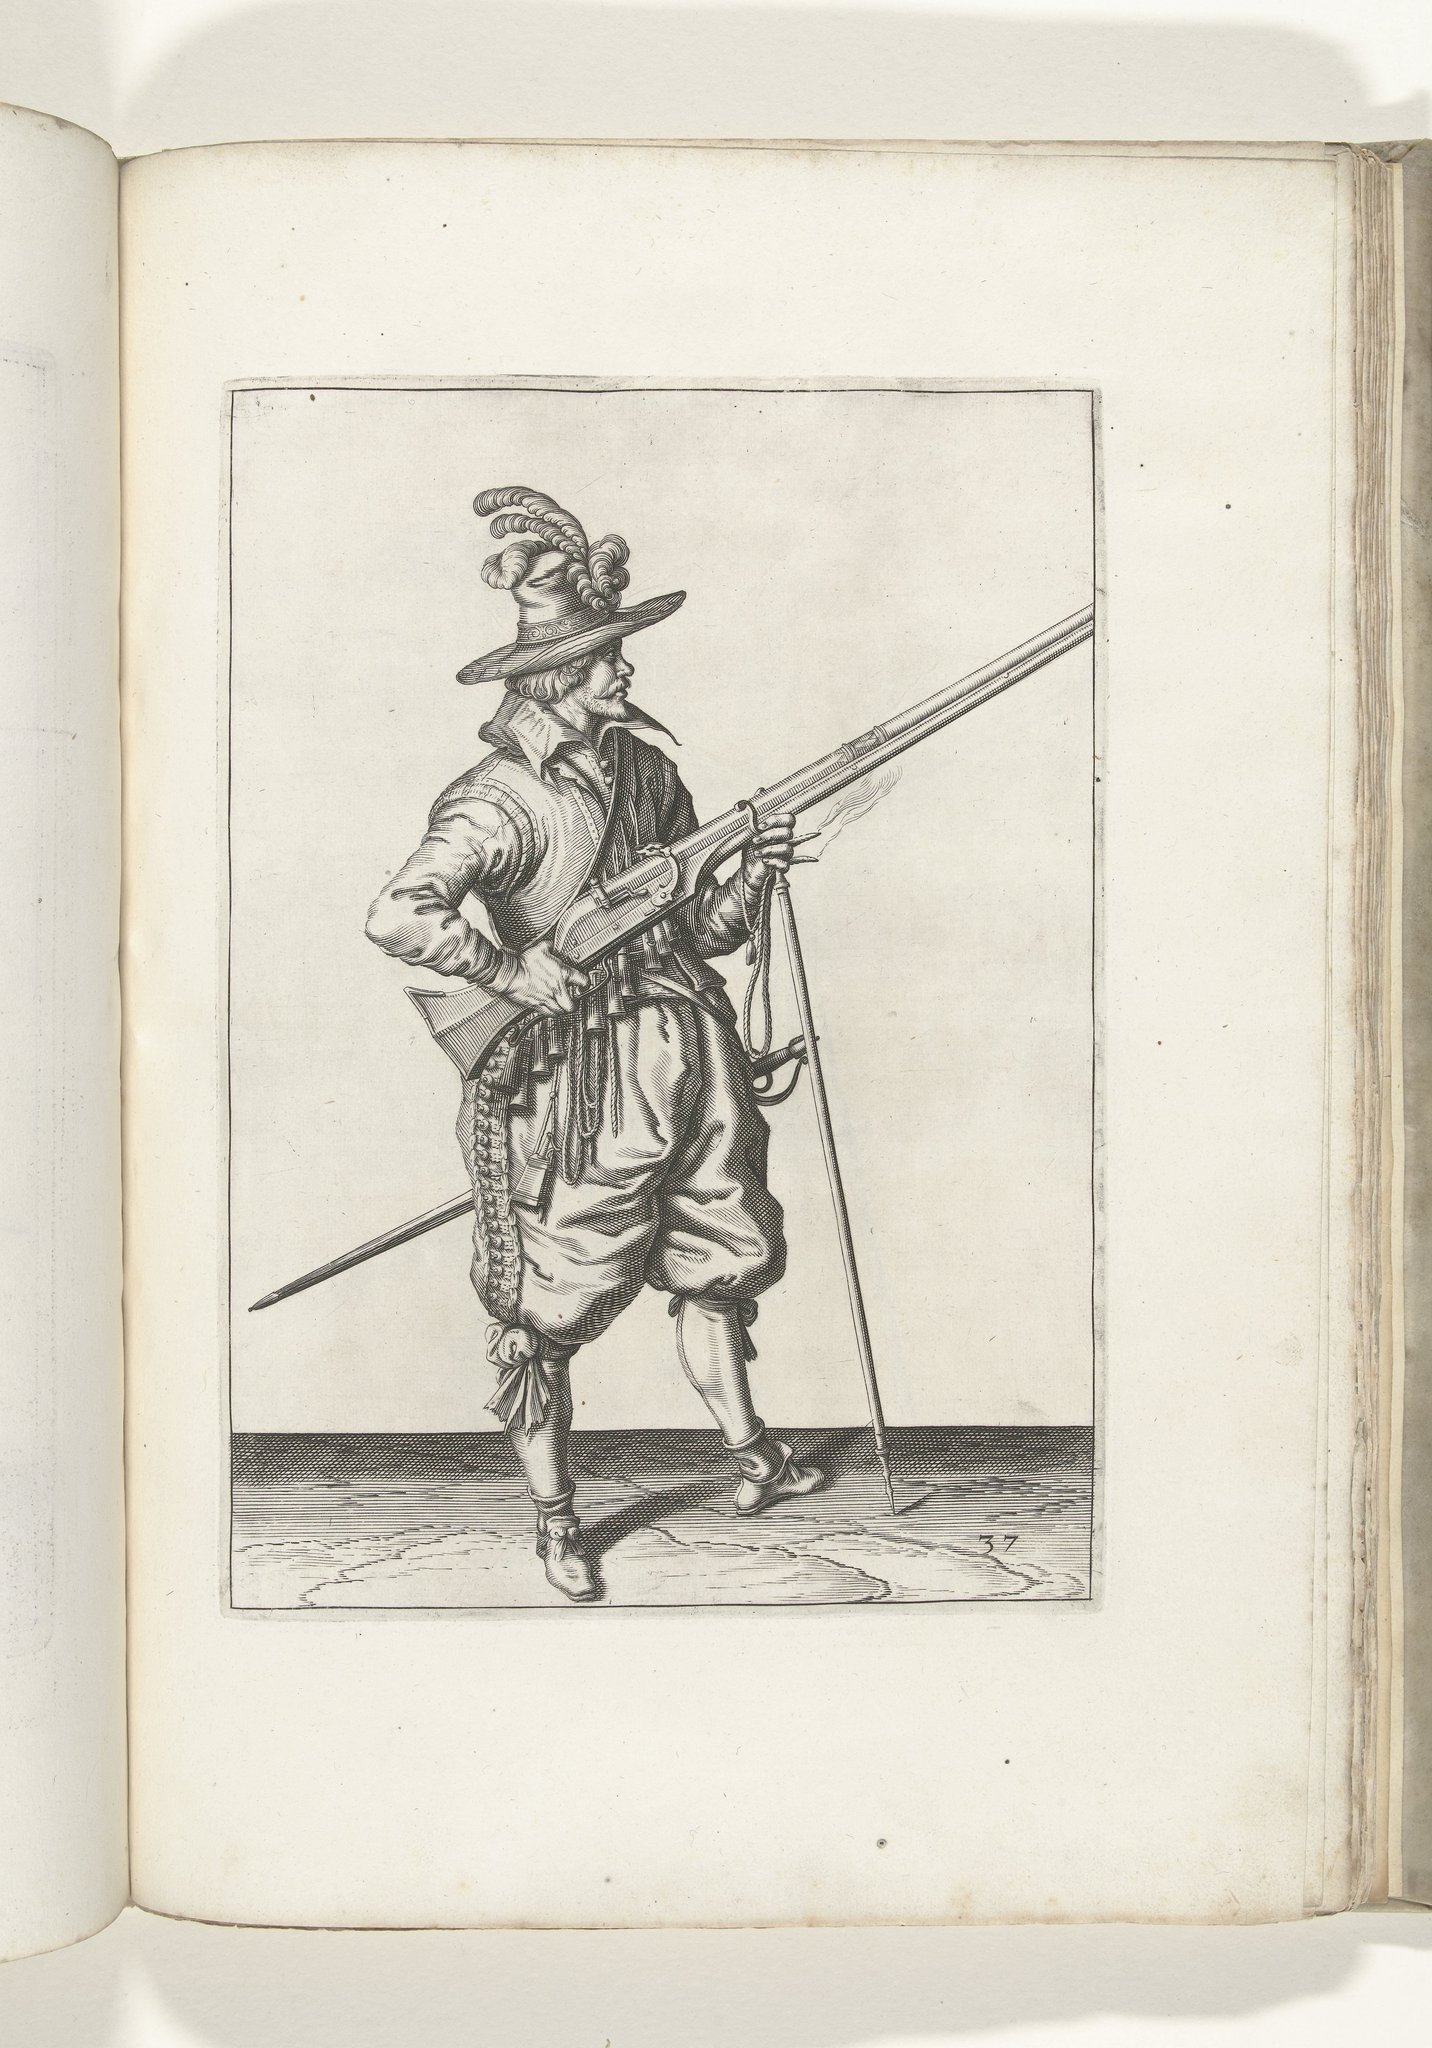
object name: print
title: Soldaat op wacht die zijn musket bij zijn rechterzijde schuin omhoog gericht vasthoudt, zijn vinger aan de trekker (nr. 37), ca. 1600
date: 1597-1607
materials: paper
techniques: engraving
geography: northern netherlands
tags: maurice (prince of orange), handling of weapons ~ military training, weapons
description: Een soldaat op wacht, ten voeten uit, naar rechts, die een musket (een bepaald type vuurwapen) bij zijn rechterzijde vasthoudt, zijn rechterwijsvinger aan de trekker, zijn linkerhand om de vork van het furket (musketvork) waarop de loop, schuin omhoog gericht, rust (nr. 37), ca. 1600. In zijn linkerhand tevens een brandende lont. Plaat 37 in de instructies voor het hanteren van het musket: Corte onderrechtinghe op de figuerliicke afbeeldinghe, soo veel aengaet het recht ghebruyck vant Musquet. Onderdeel van de illustraties in: J. de Gheyn, Wapenhandelinghe van Roers Musquetten ende spiessen, 's-Gravenhage, 1607. Krijgswezen rond 1600.